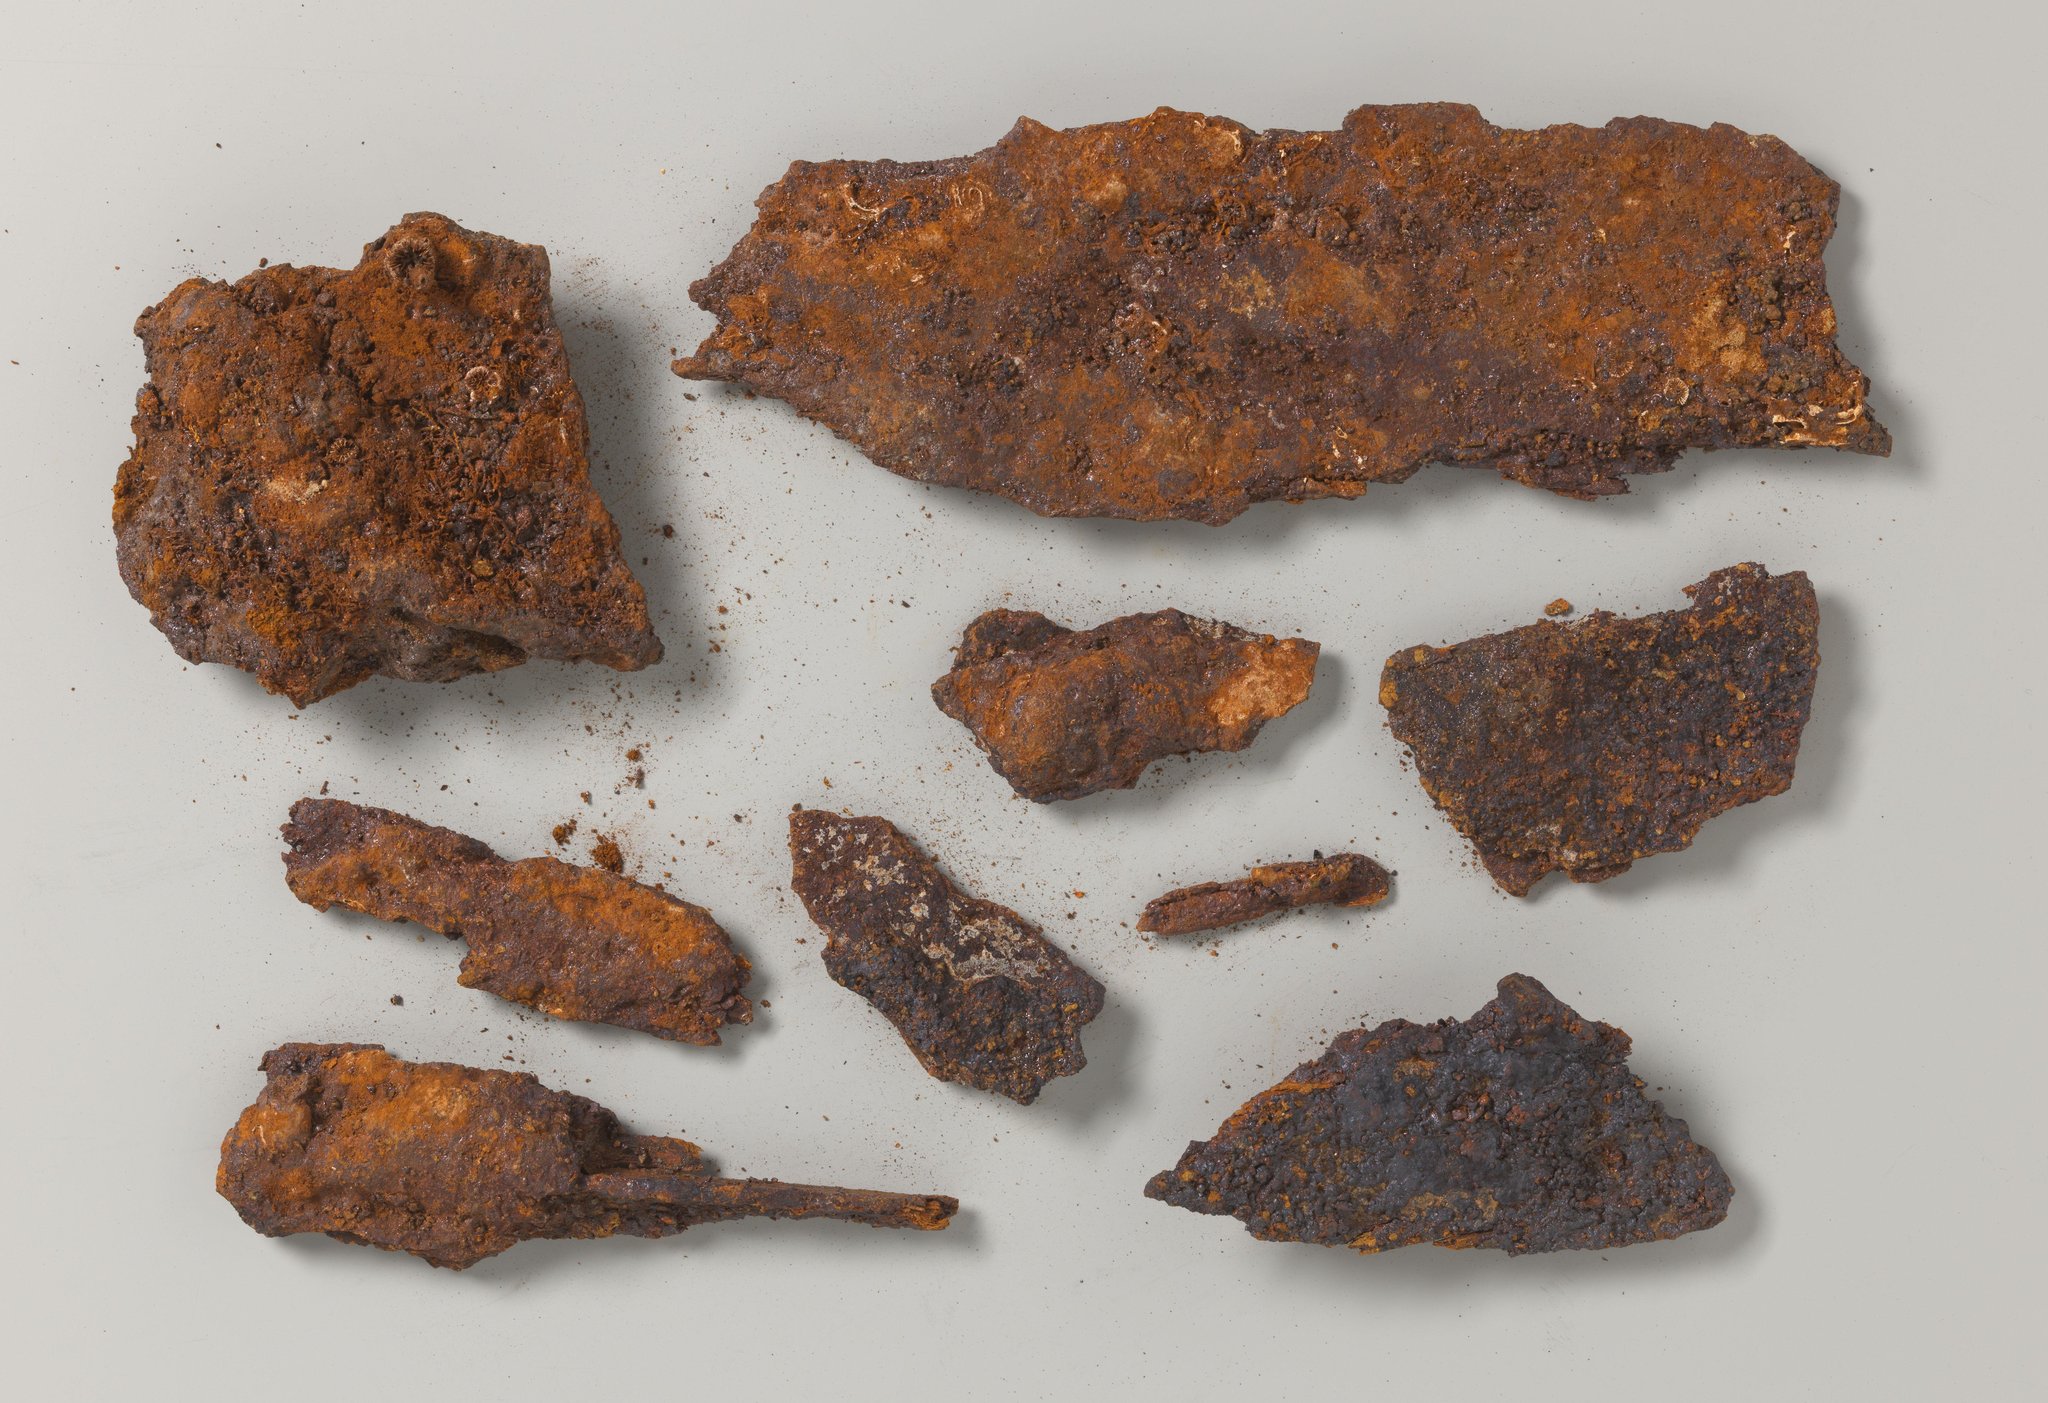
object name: fragment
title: Houtfragmenten in concretie uit het wrak van de Oostindiëvaarder Hollandia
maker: Anonymous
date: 1700-1743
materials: stone, wood